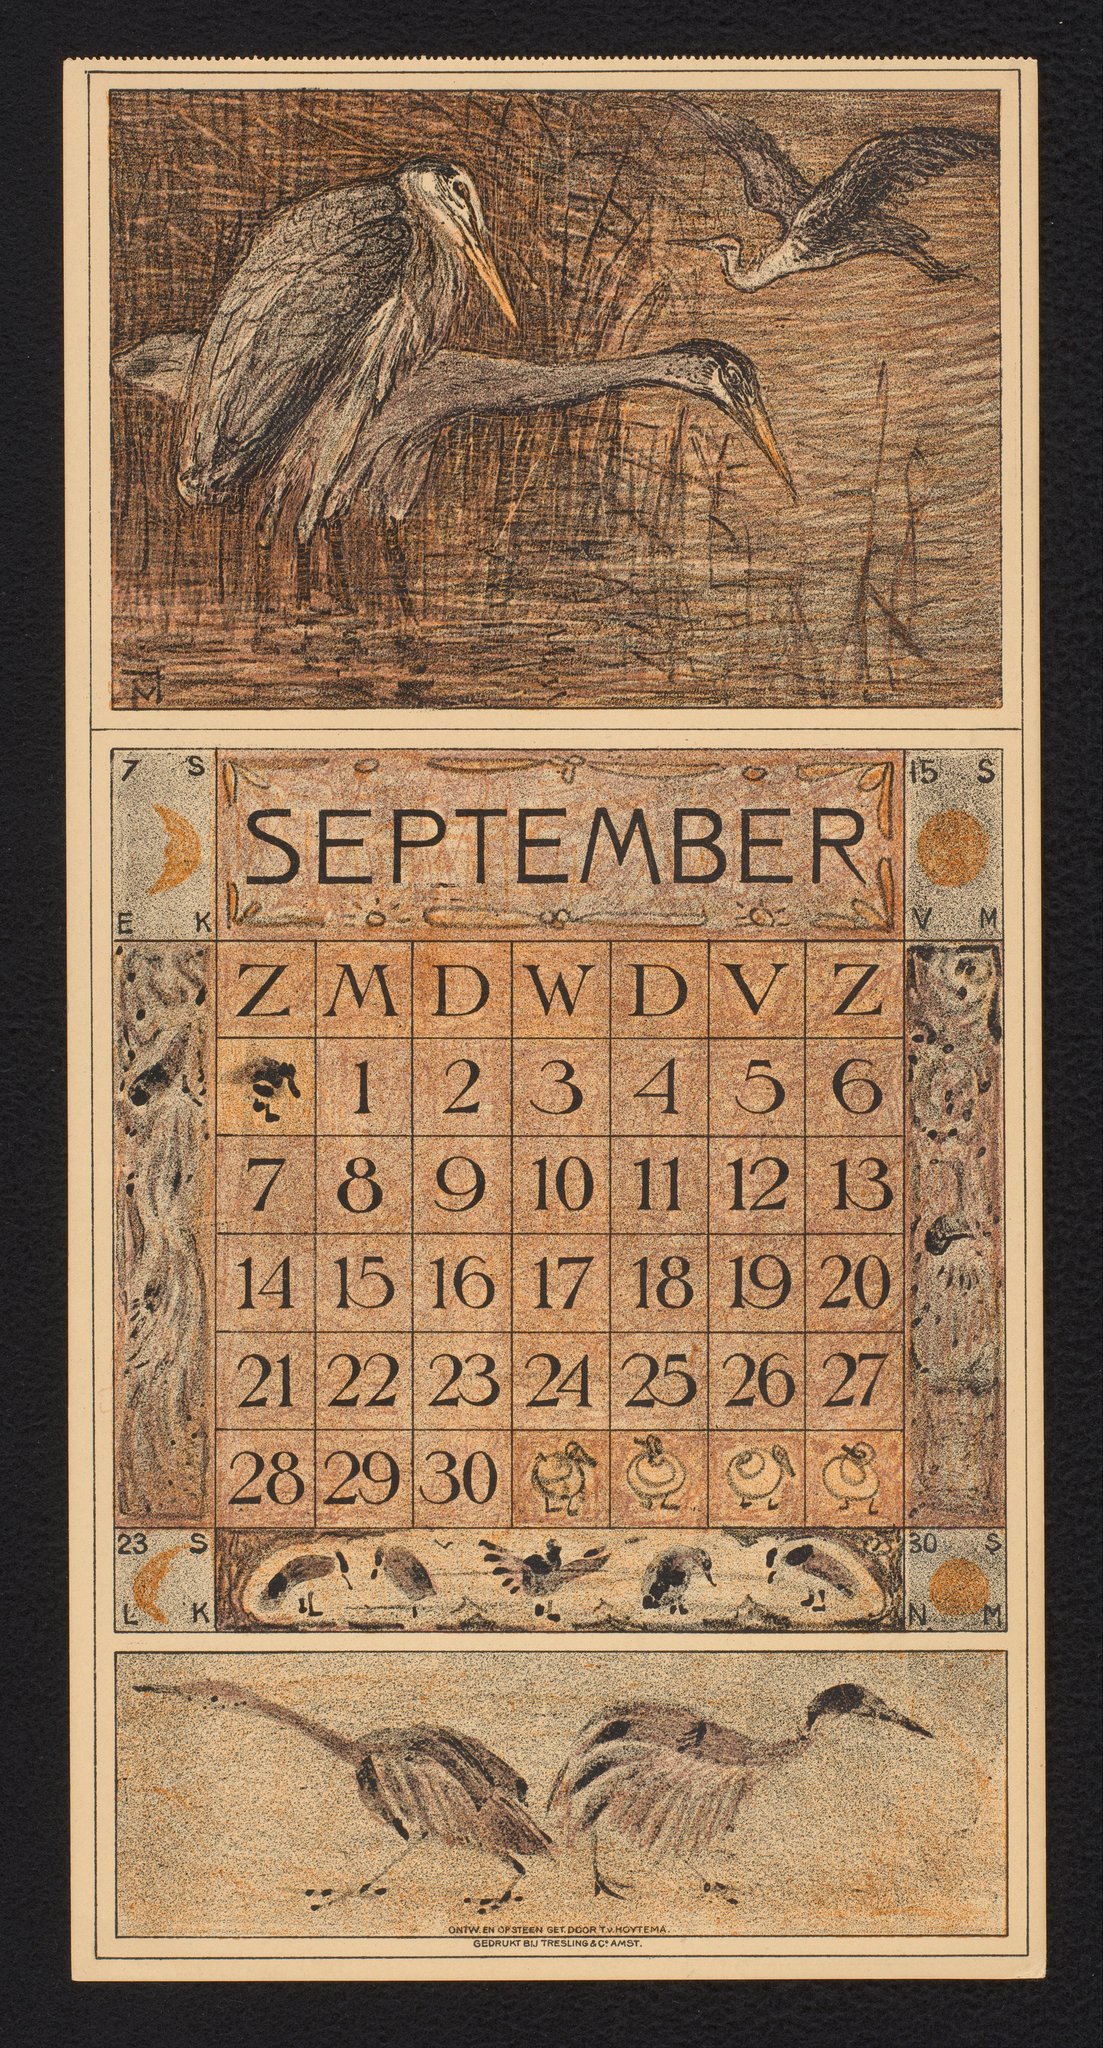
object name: calendar leaf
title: Kalenderblad voor september 1913 met reigers in het riet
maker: theo van hoytema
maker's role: draughtsman, painter, print maker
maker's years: 1863-1917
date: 1912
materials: paper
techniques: lithograph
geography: amsterdam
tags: shore-birds and wading-birds: heron